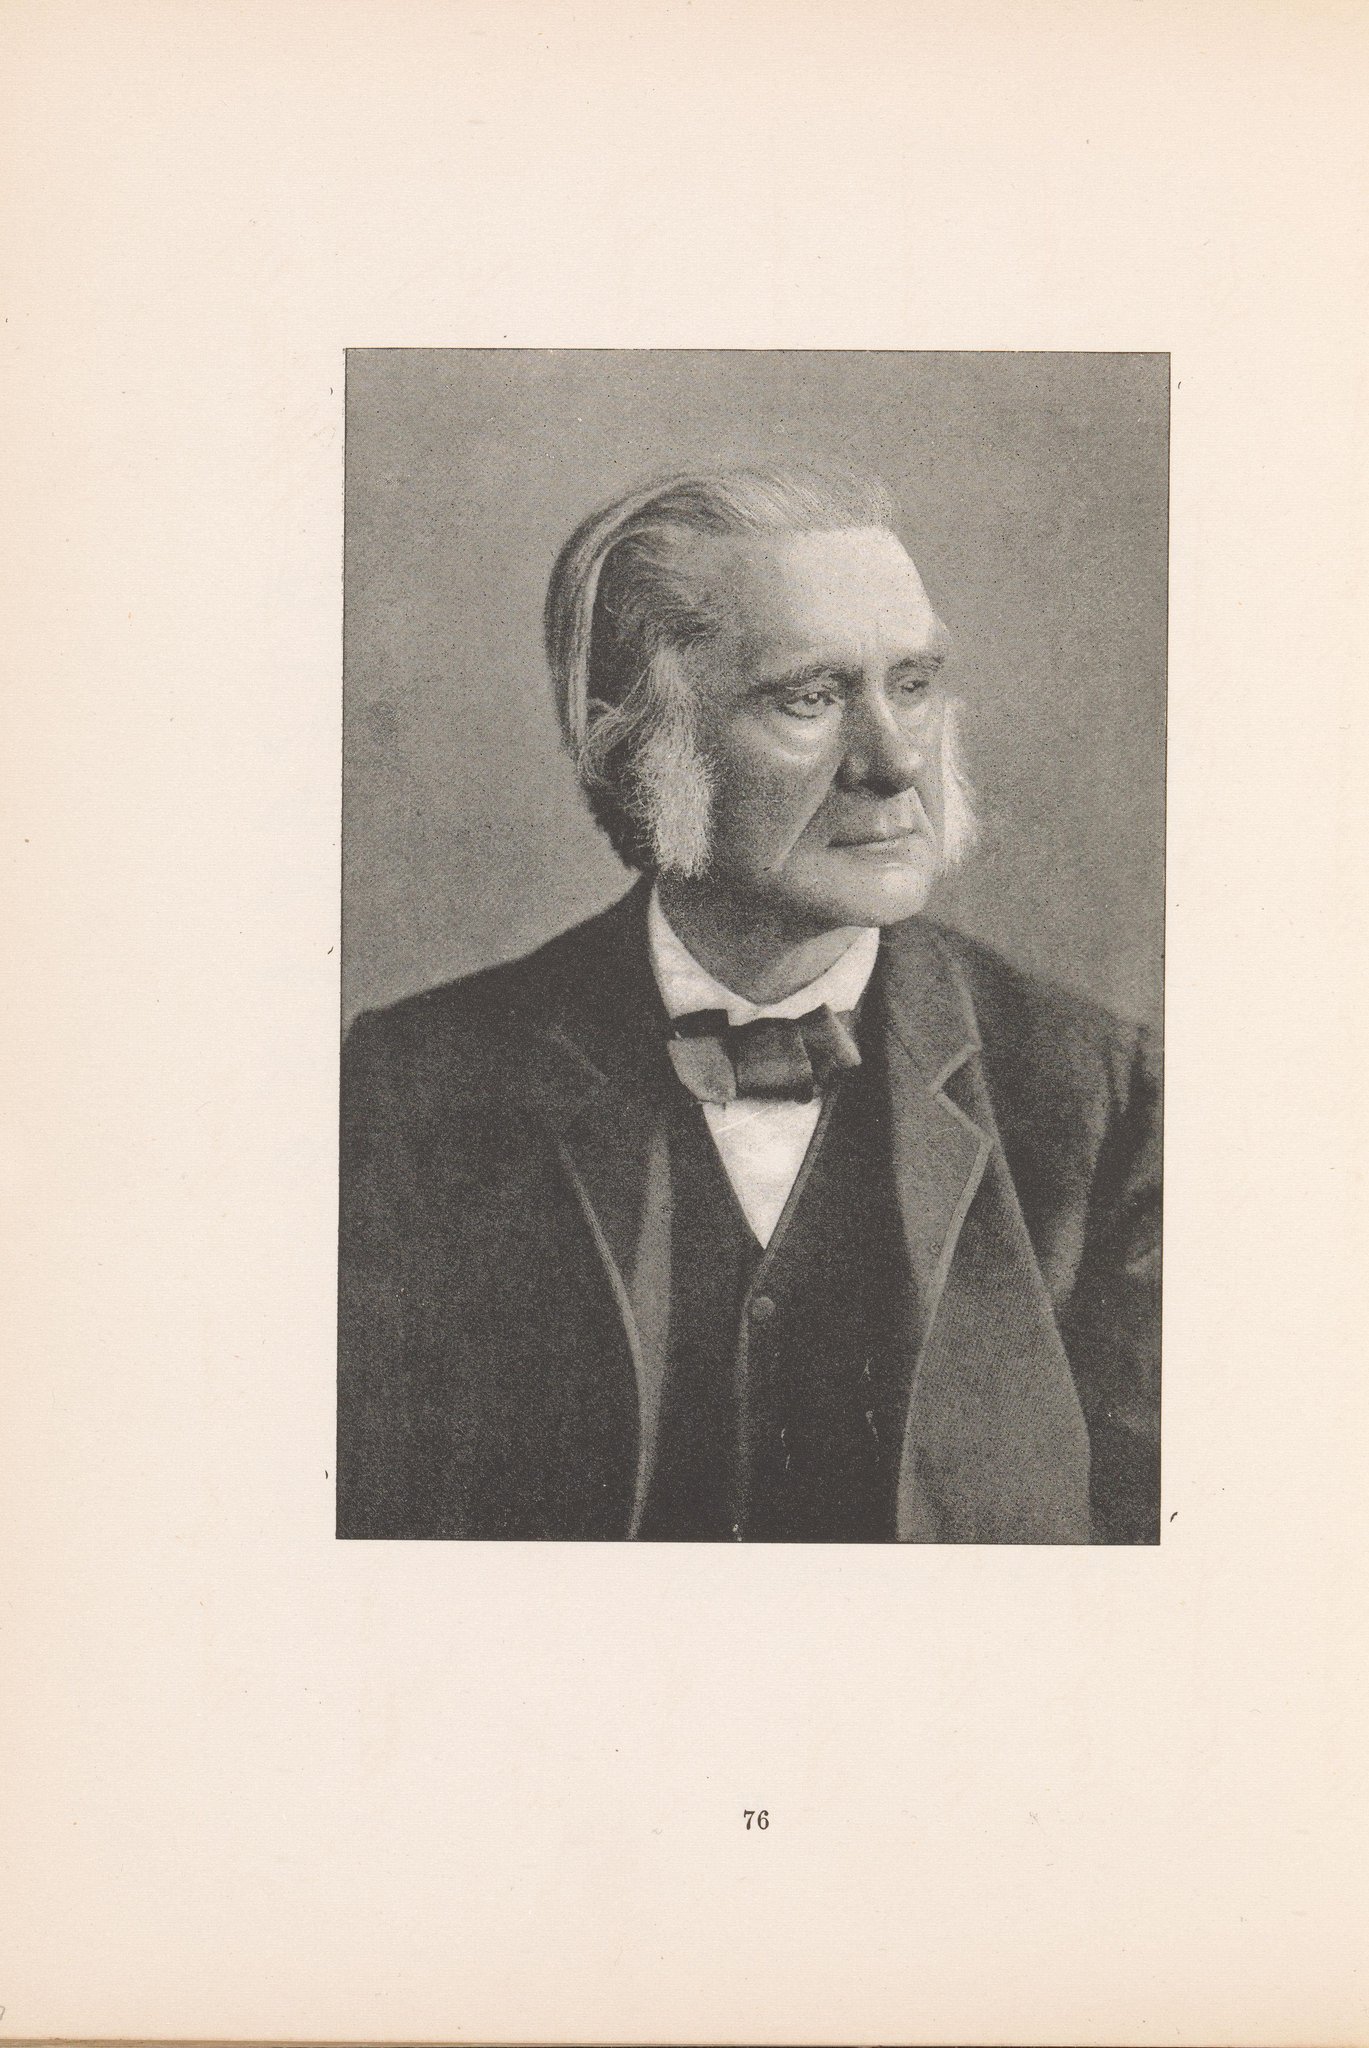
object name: page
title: Portret van Thomas Henry Huxley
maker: Anonymous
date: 1881-1891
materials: paper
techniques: autotype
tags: historical persons